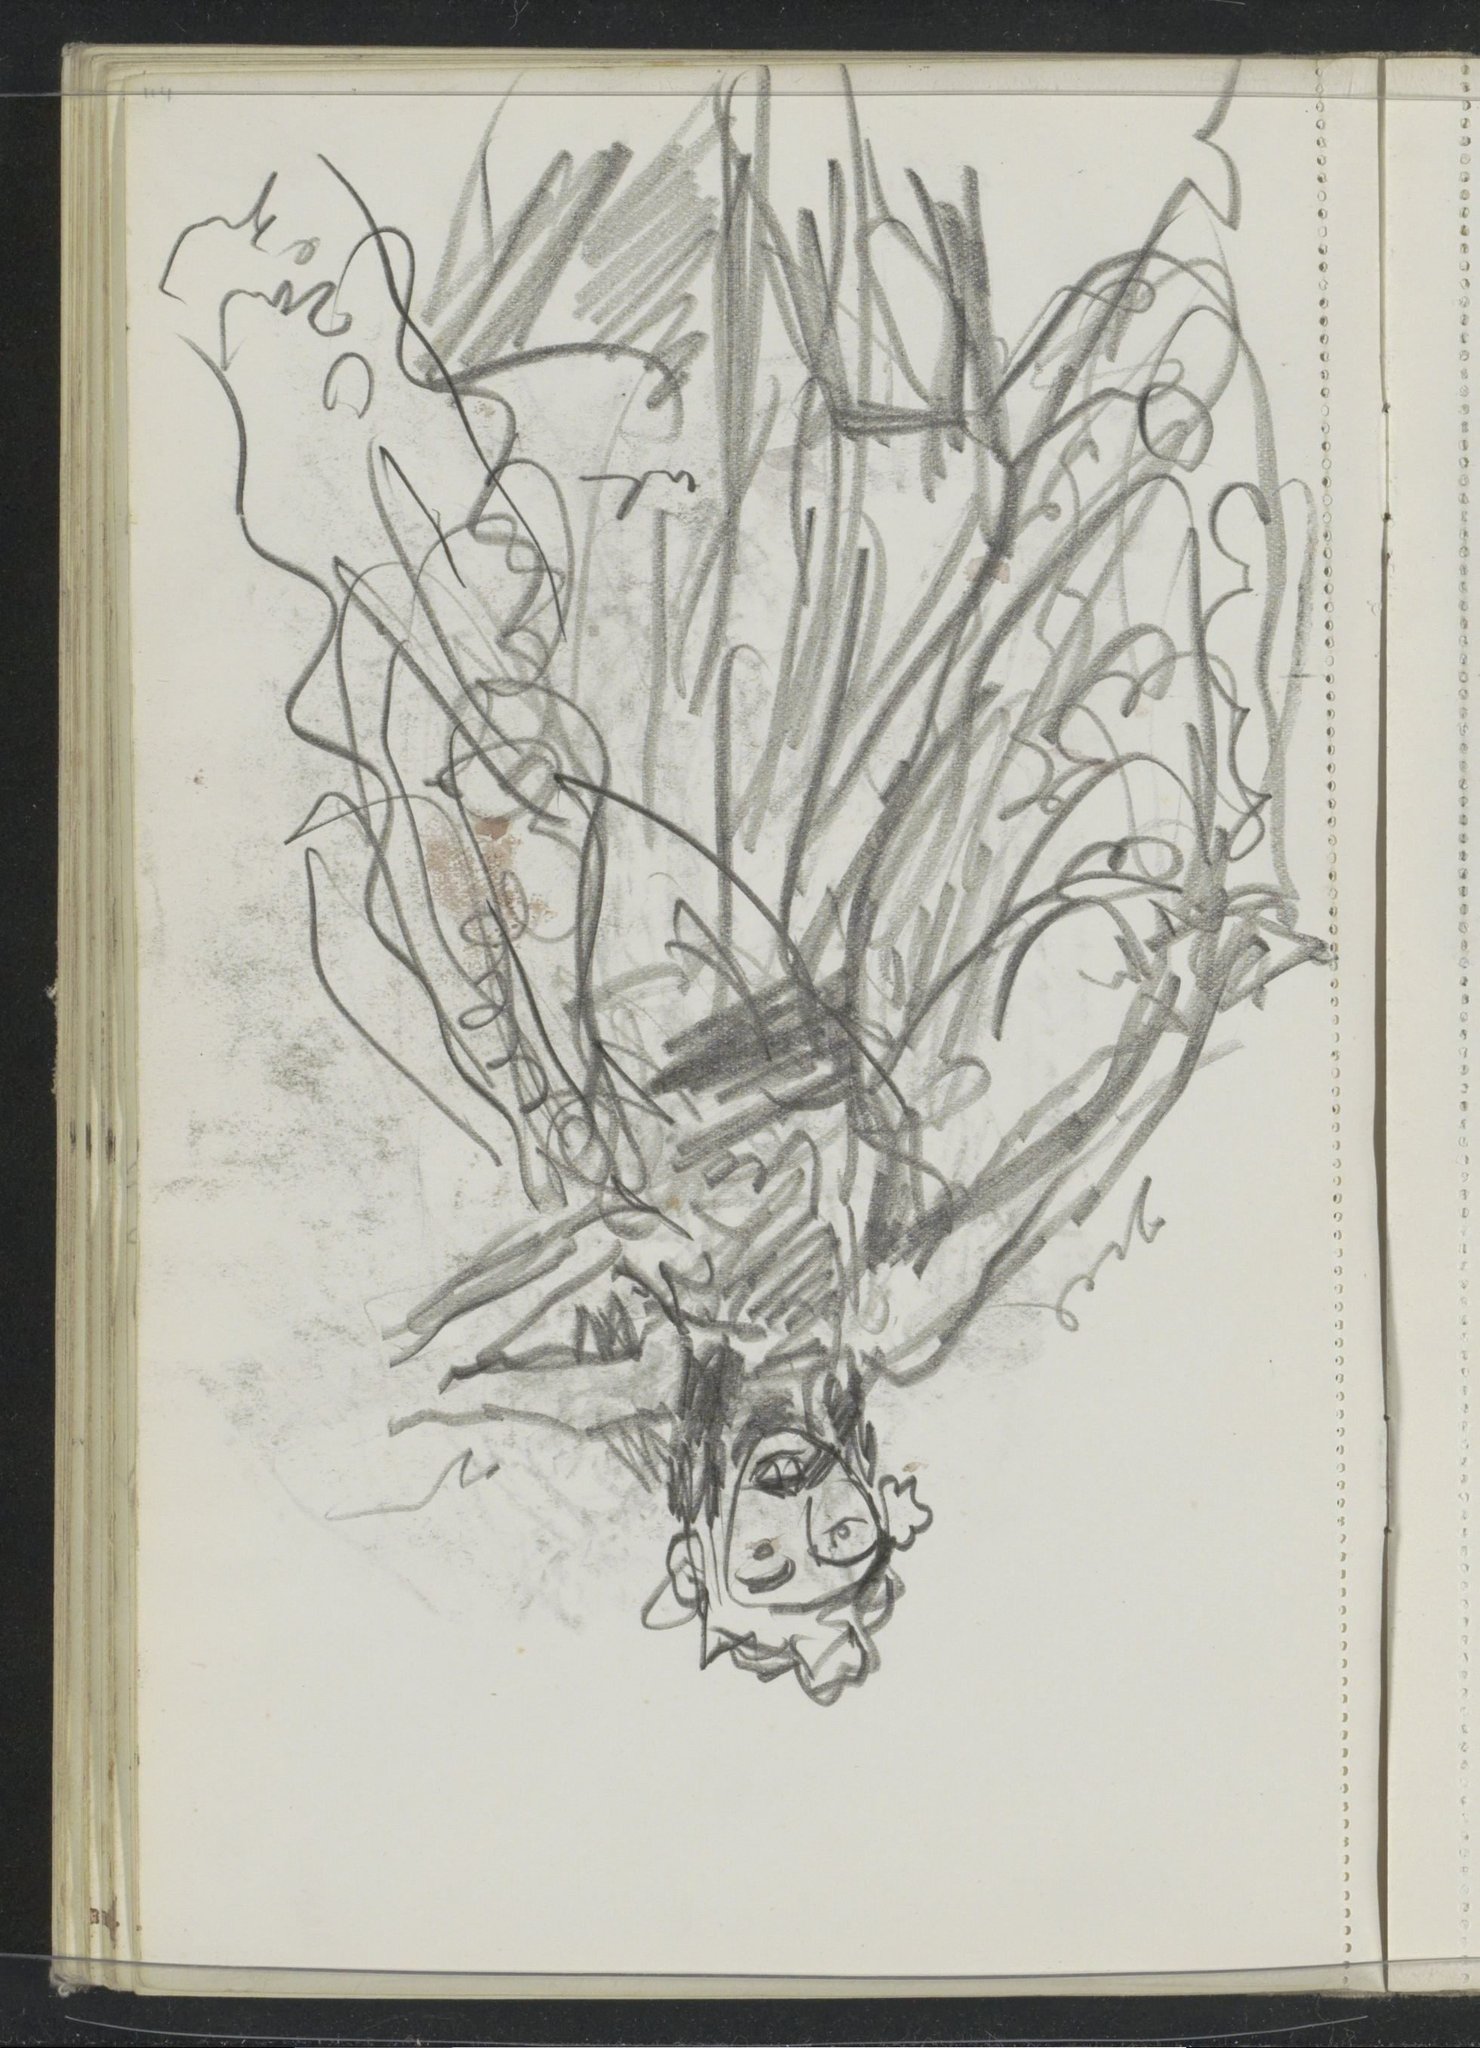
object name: sketchbook leaf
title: Danser in traditioneel Indonesisch kostuum met masker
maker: marius bauer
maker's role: draughtsman, print maker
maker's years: 1867-1932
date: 1925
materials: paper, pencil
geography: indonesia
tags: mask, folk costume, regional costume, one person dancing alone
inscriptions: kleurnotitie, handgeschreven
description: Pagina 114 uit een schetsboek met 74 bladen.